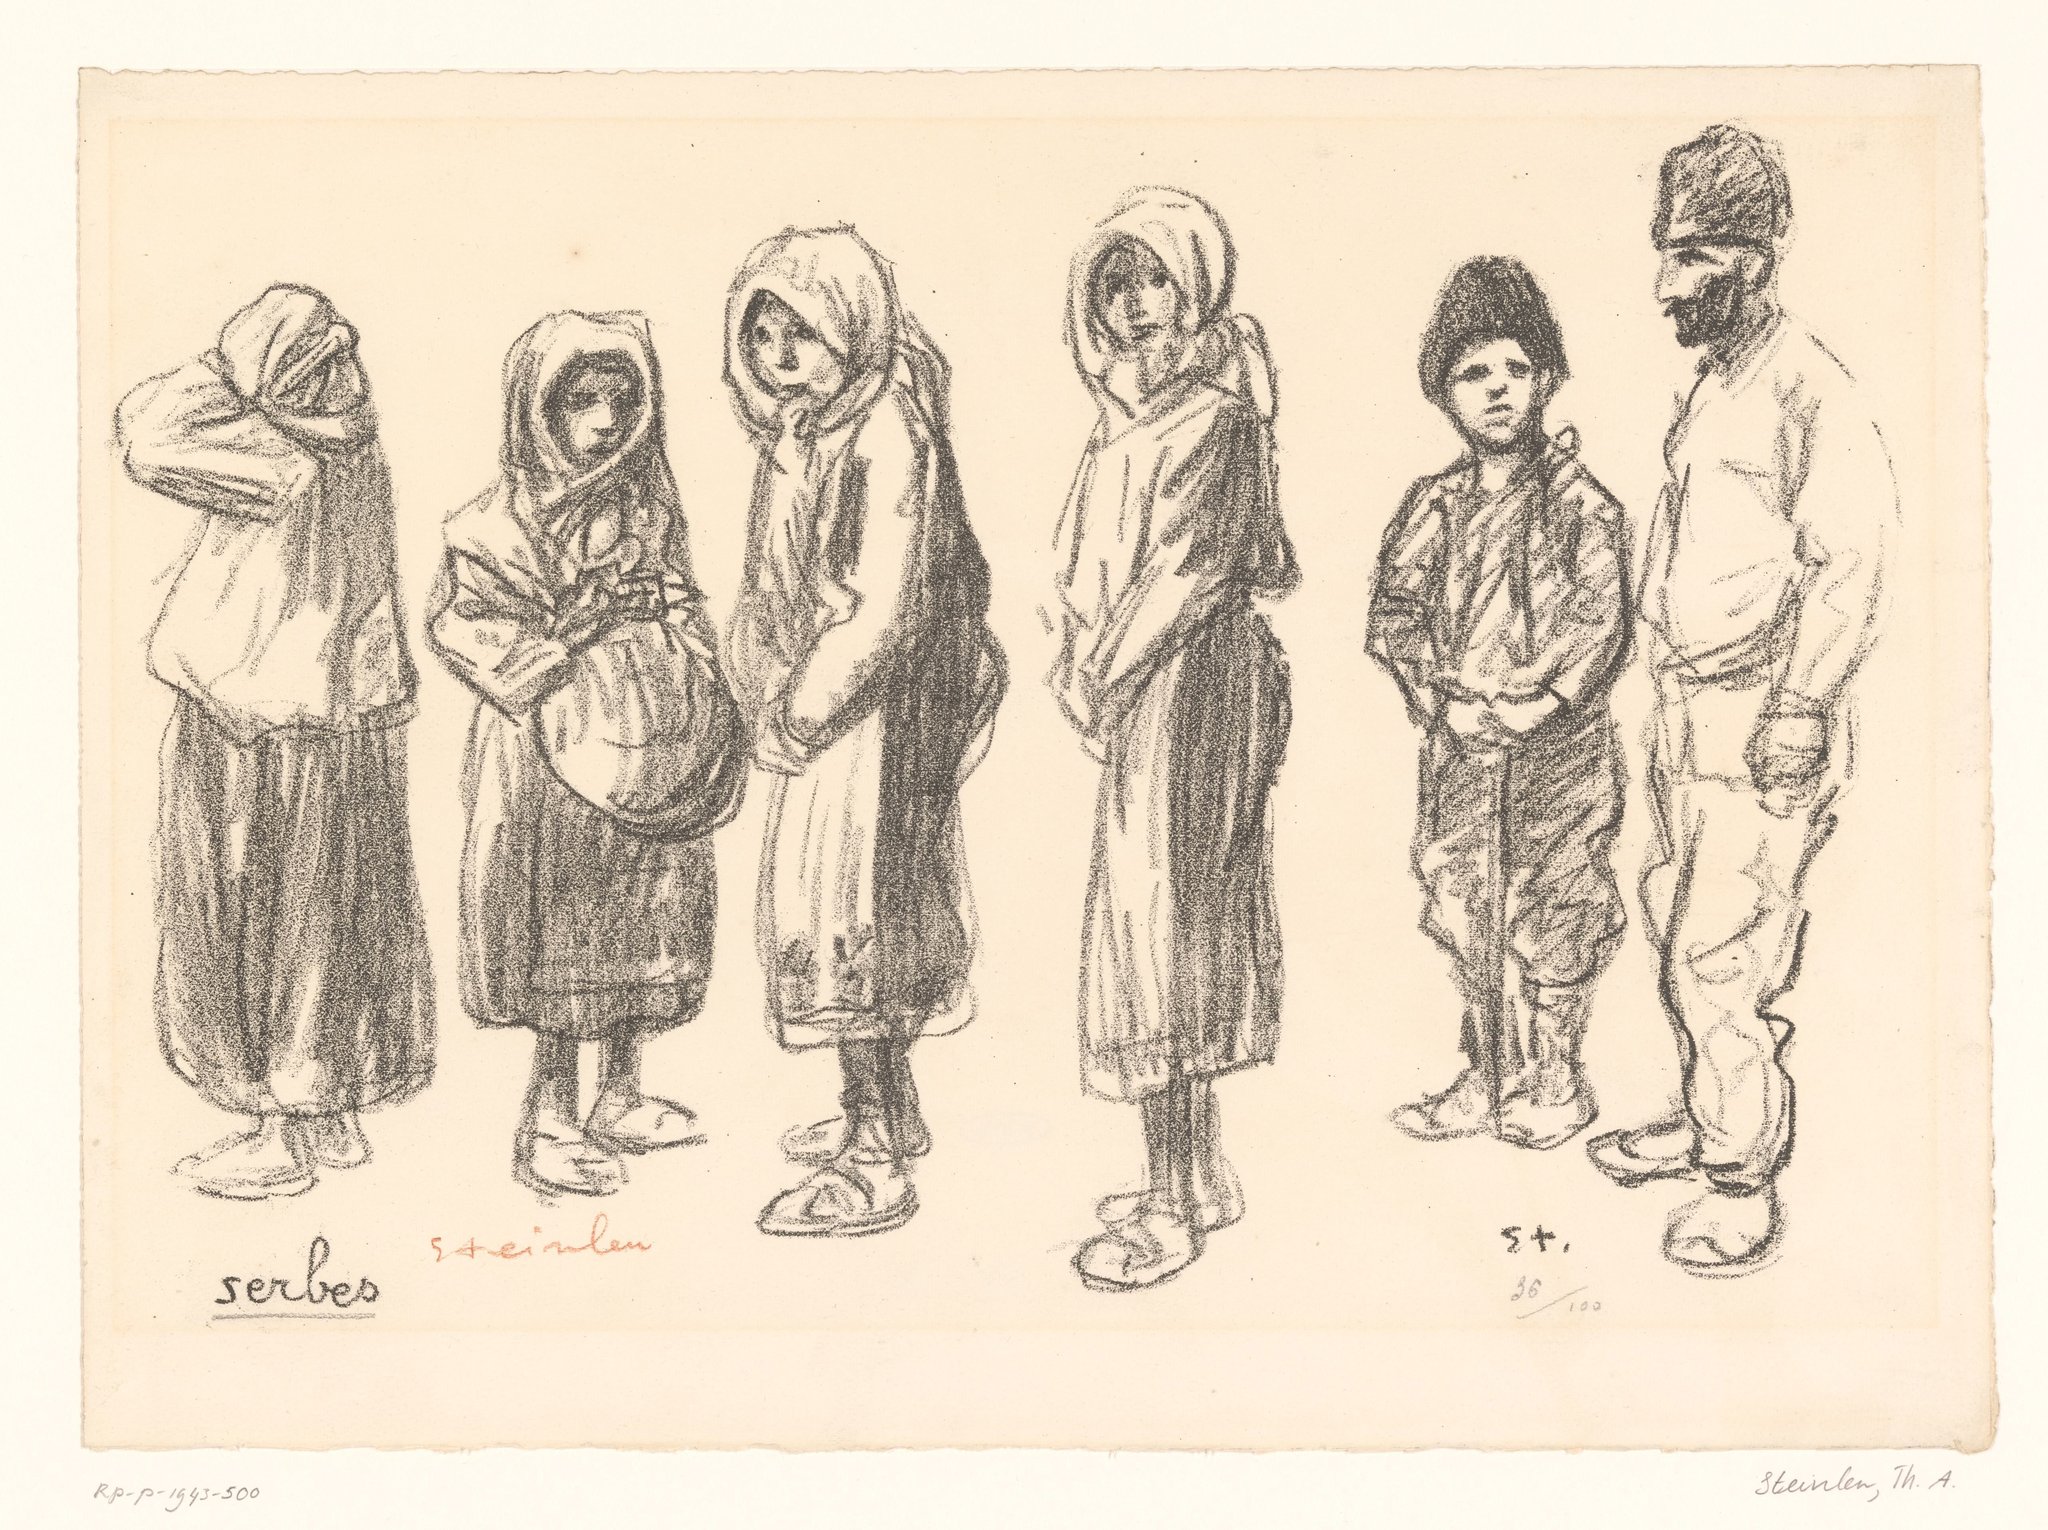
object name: print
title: Serbes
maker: théophile alexandre steinlen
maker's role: draughtsman, painter, print maker, sculptor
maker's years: 1859-1923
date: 1879-1923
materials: paper, pencil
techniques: lithograph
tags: farmers, political refugee, 'émigré'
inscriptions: signature: ‘Steinlen’, collector's mark: Lugt 2228